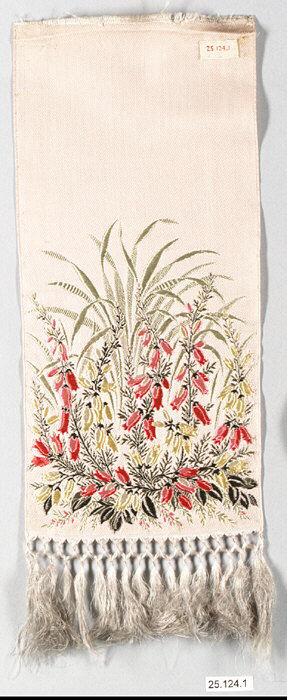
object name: necktie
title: Woman's necktie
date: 1870-1880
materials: silk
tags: flowers